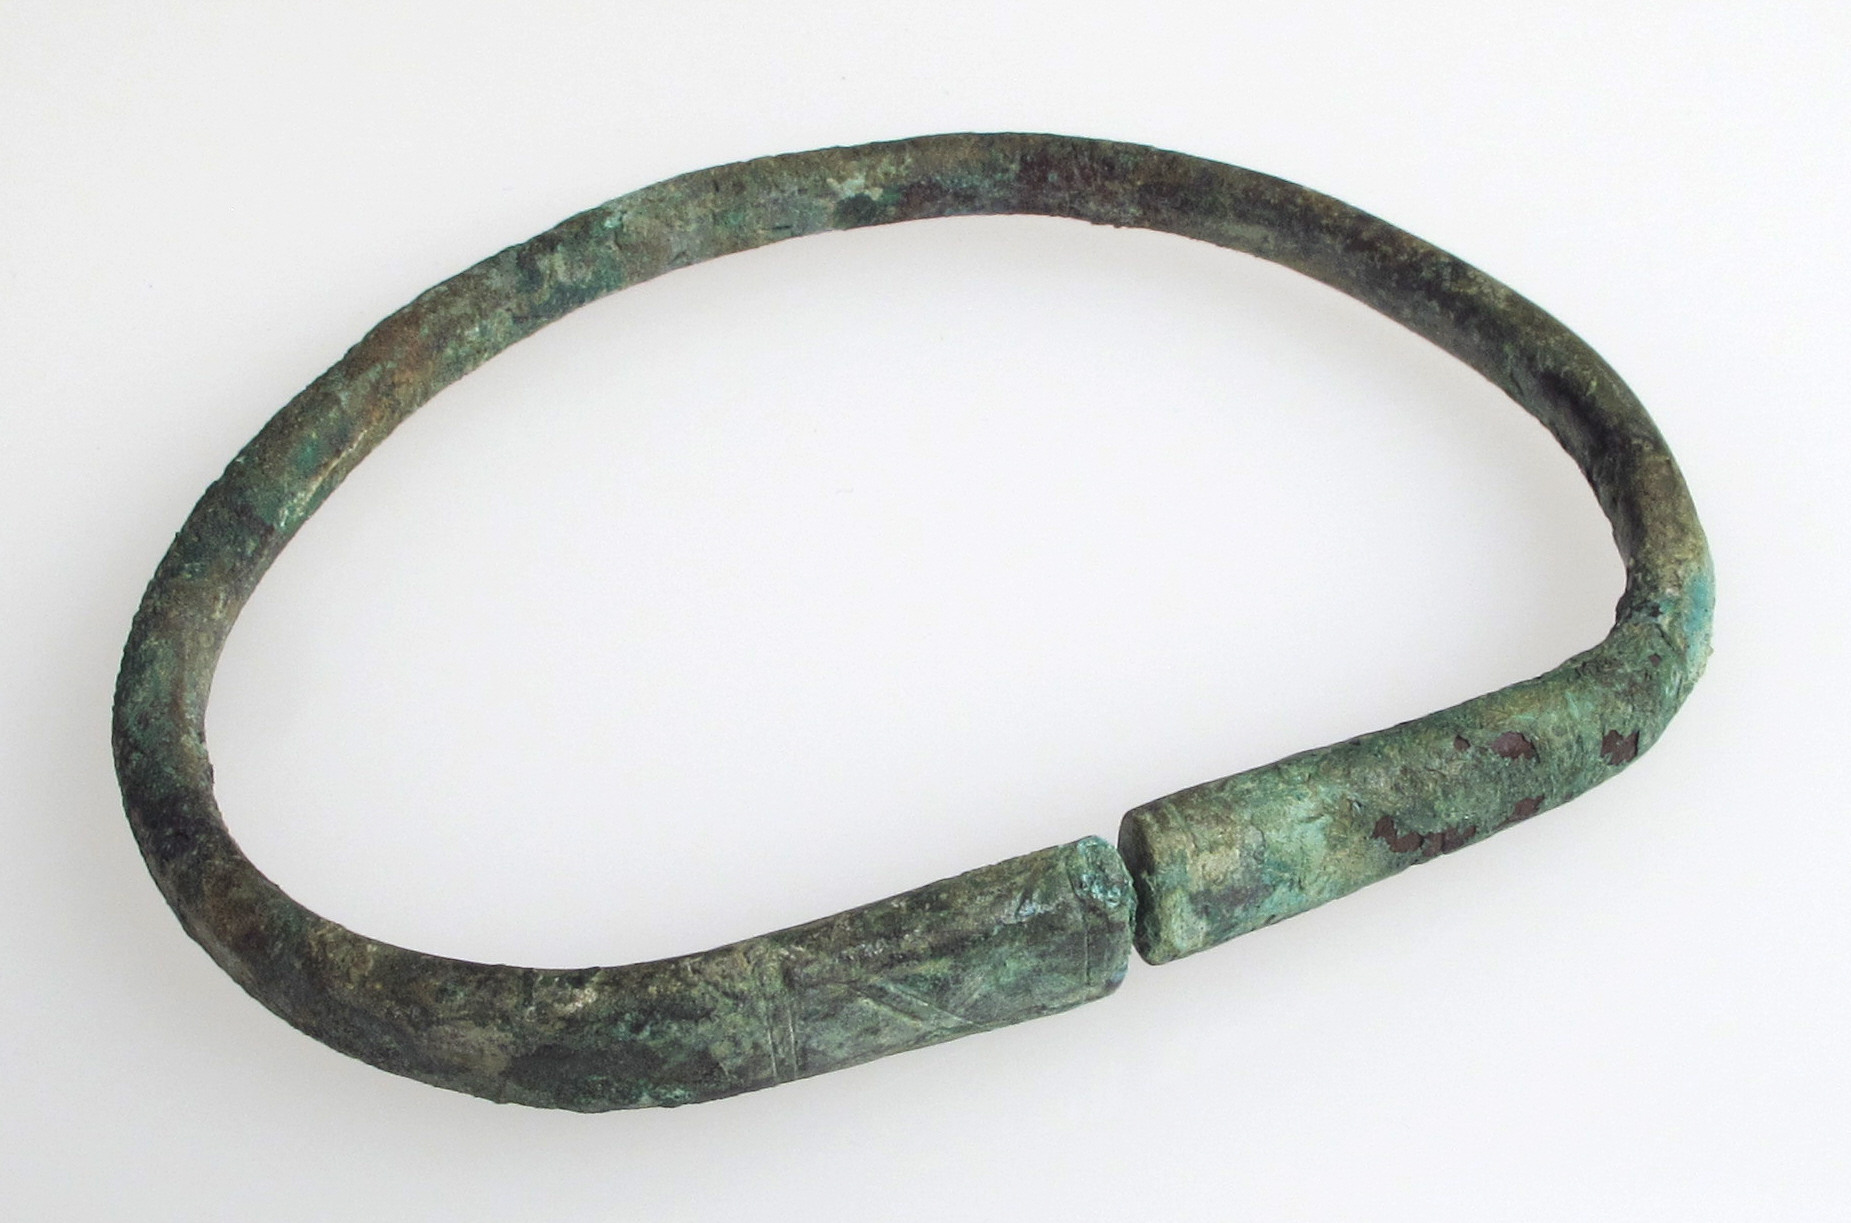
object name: armlet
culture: celtic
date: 500-401 BCE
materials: copper alloy